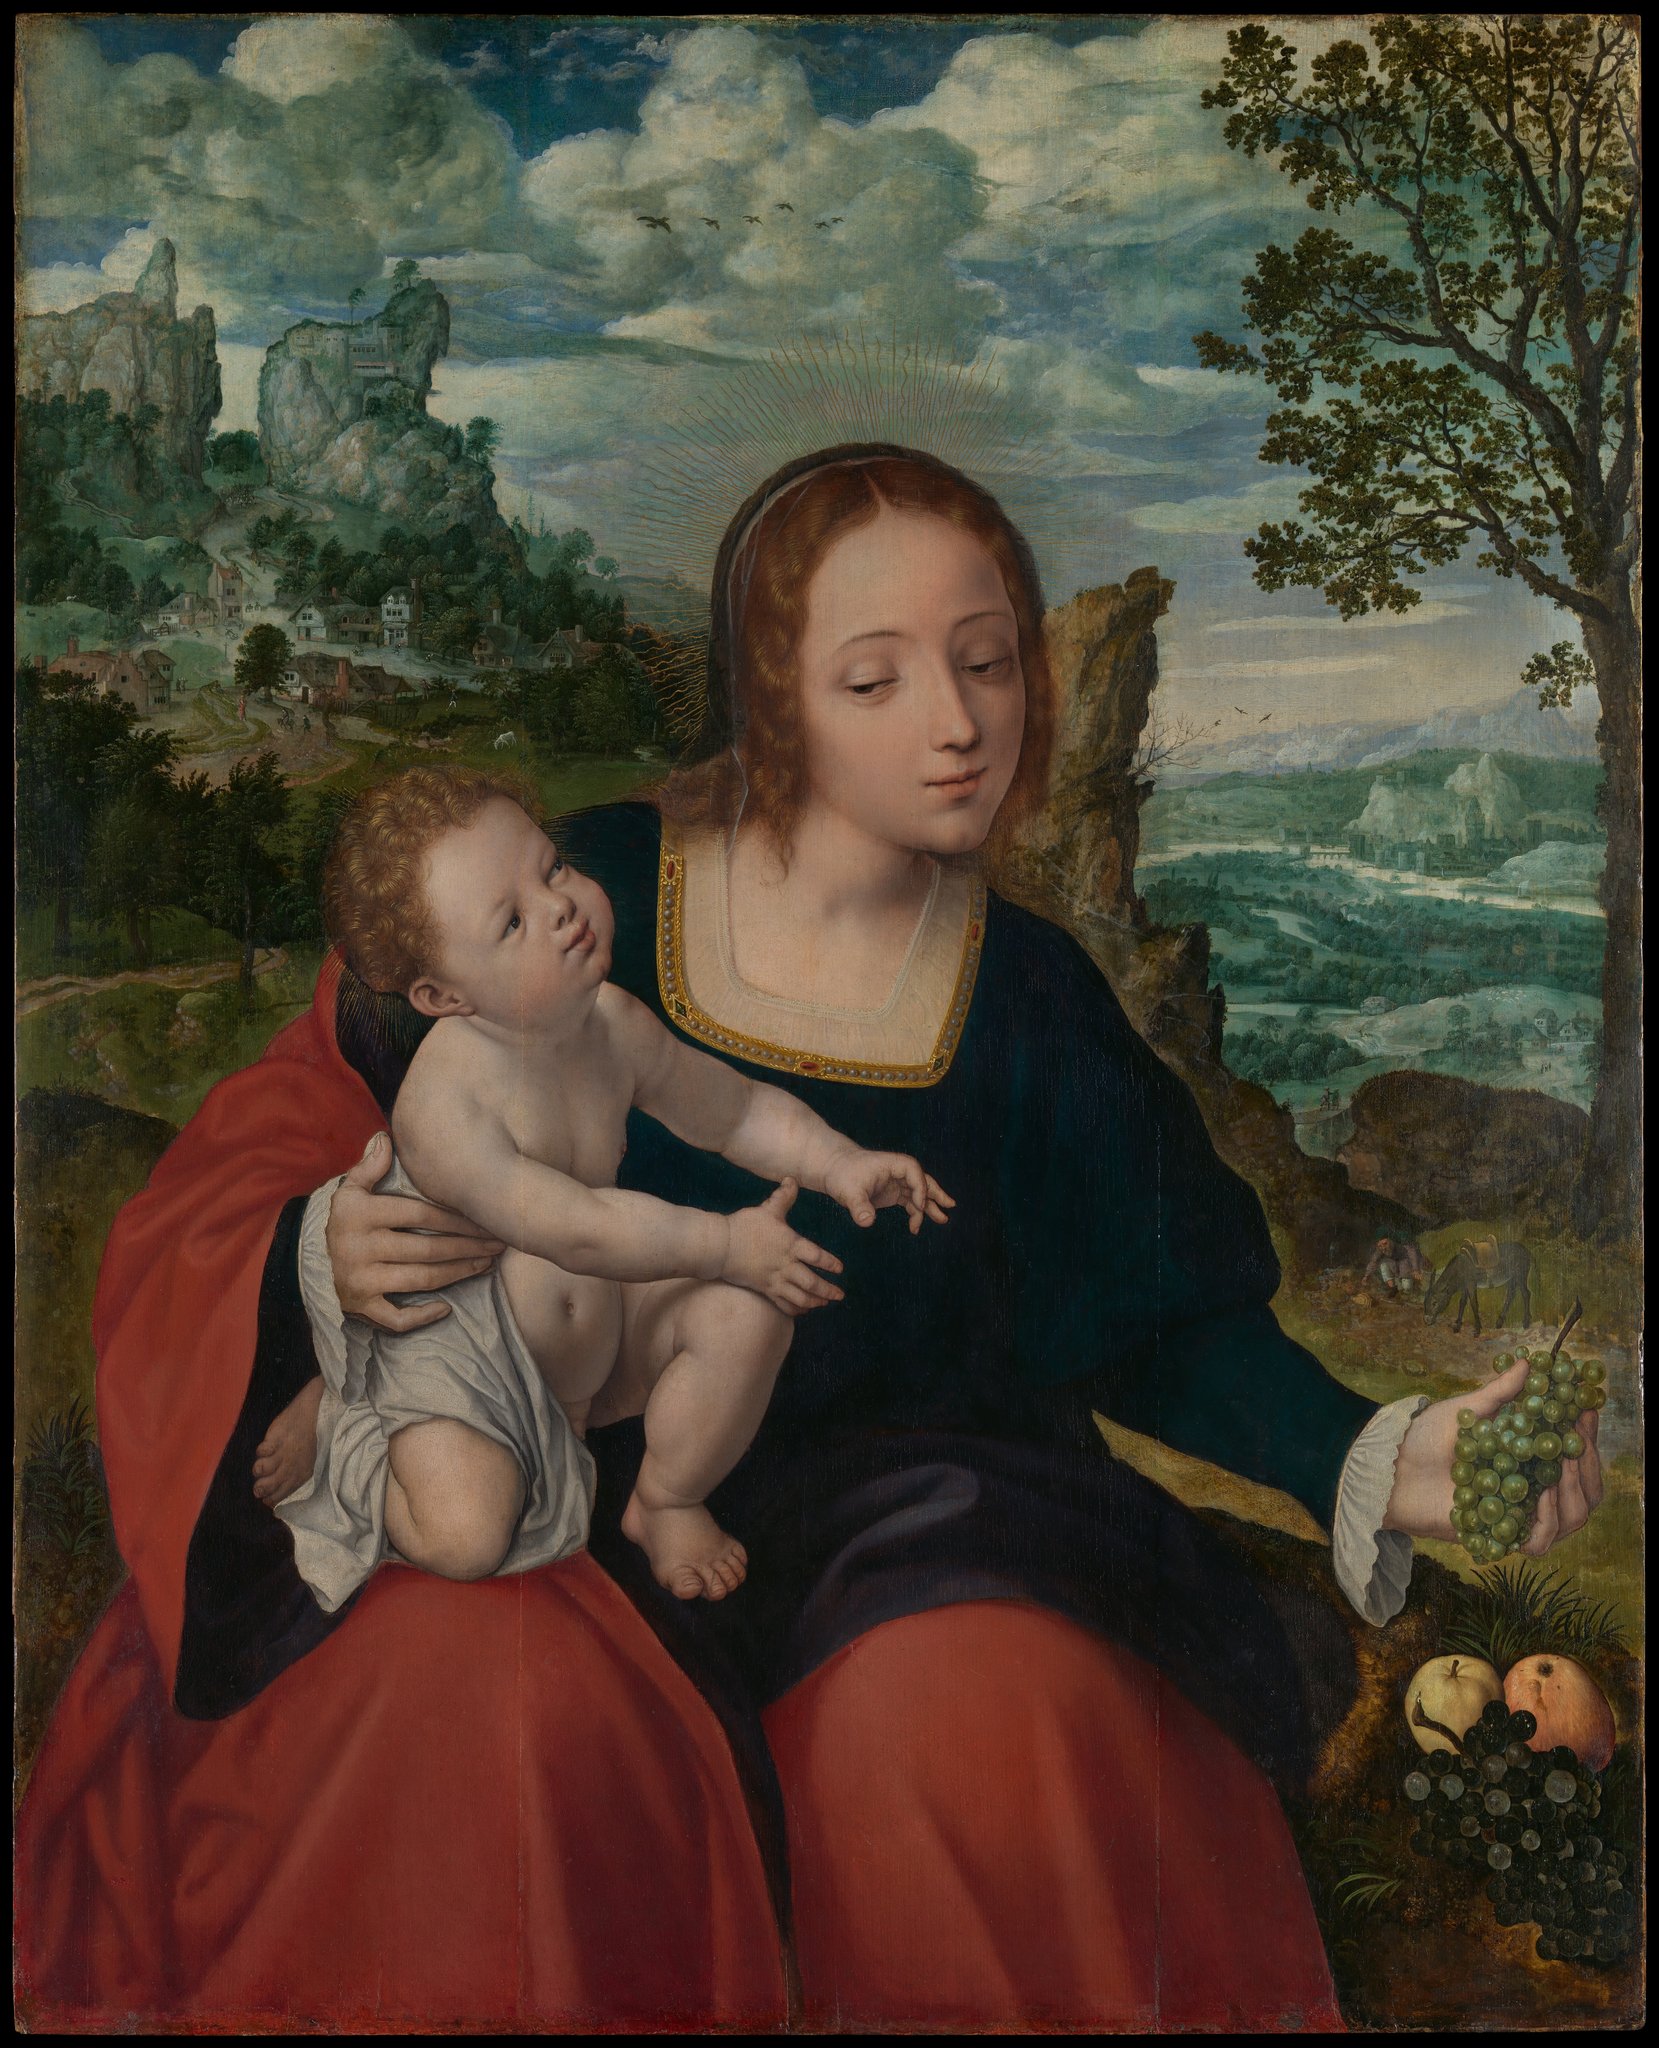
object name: painting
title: The Rest on the Flight into Egypt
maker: jan massys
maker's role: artist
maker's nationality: netherlandish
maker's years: 1504-1573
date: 1537-1540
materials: oil, wood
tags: grapes,madonna and child